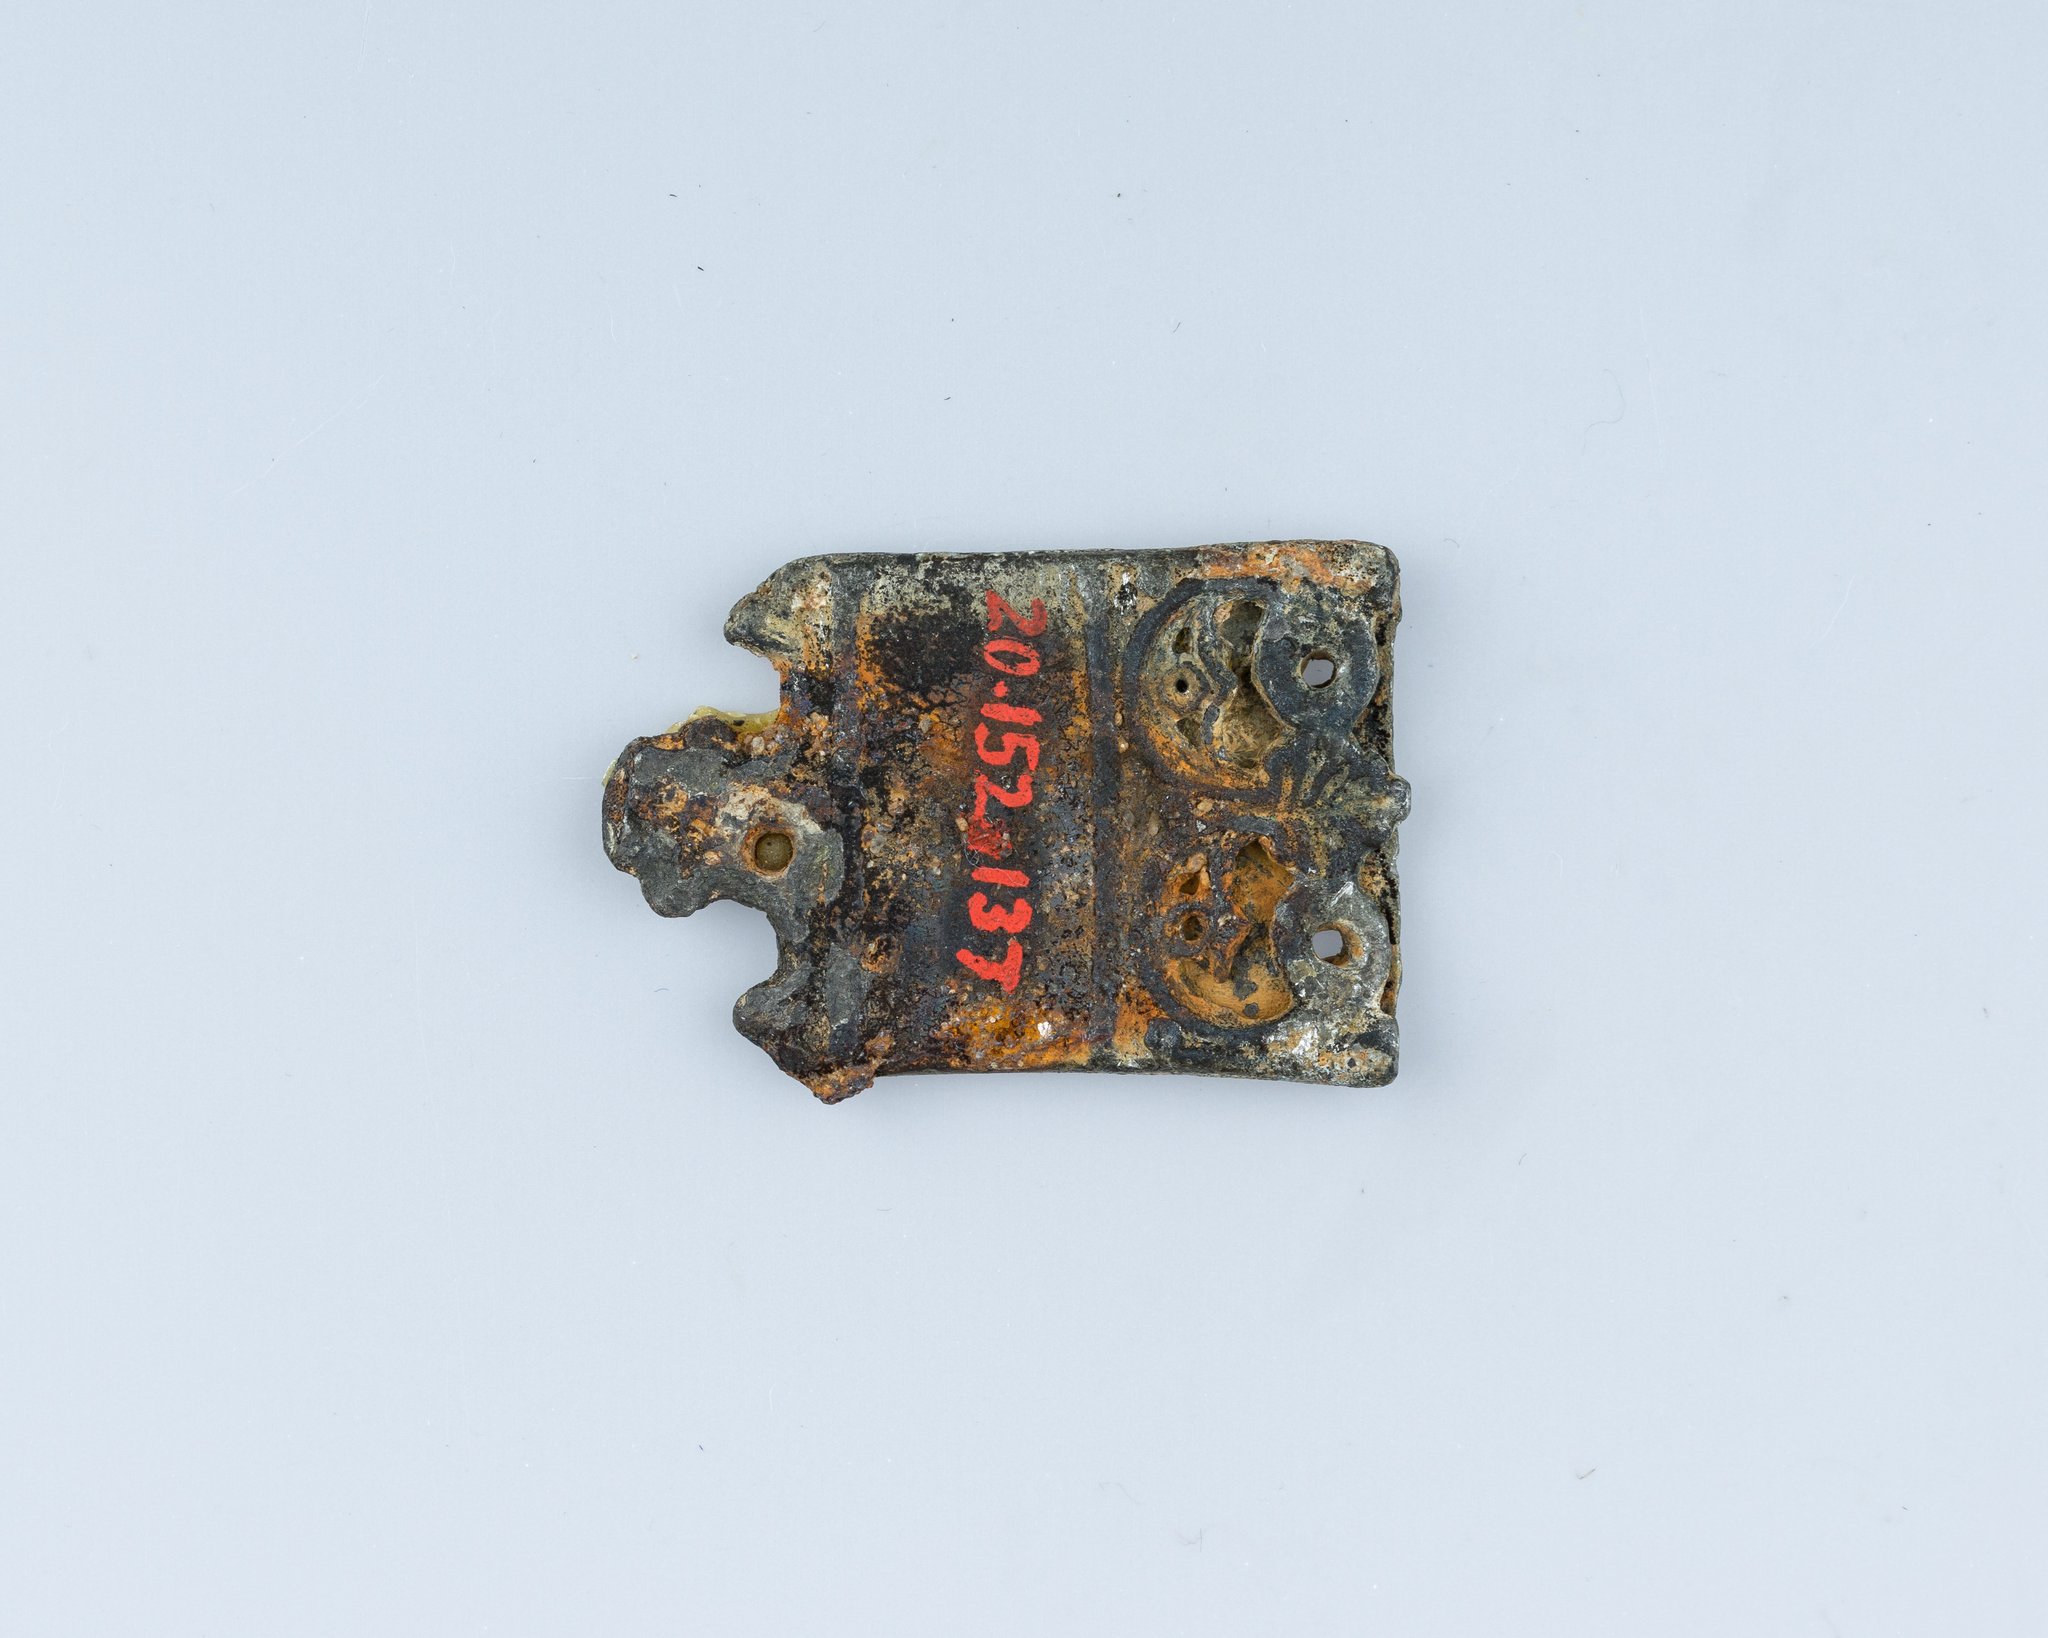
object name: mordant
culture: french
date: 1501-1533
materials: bronze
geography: france